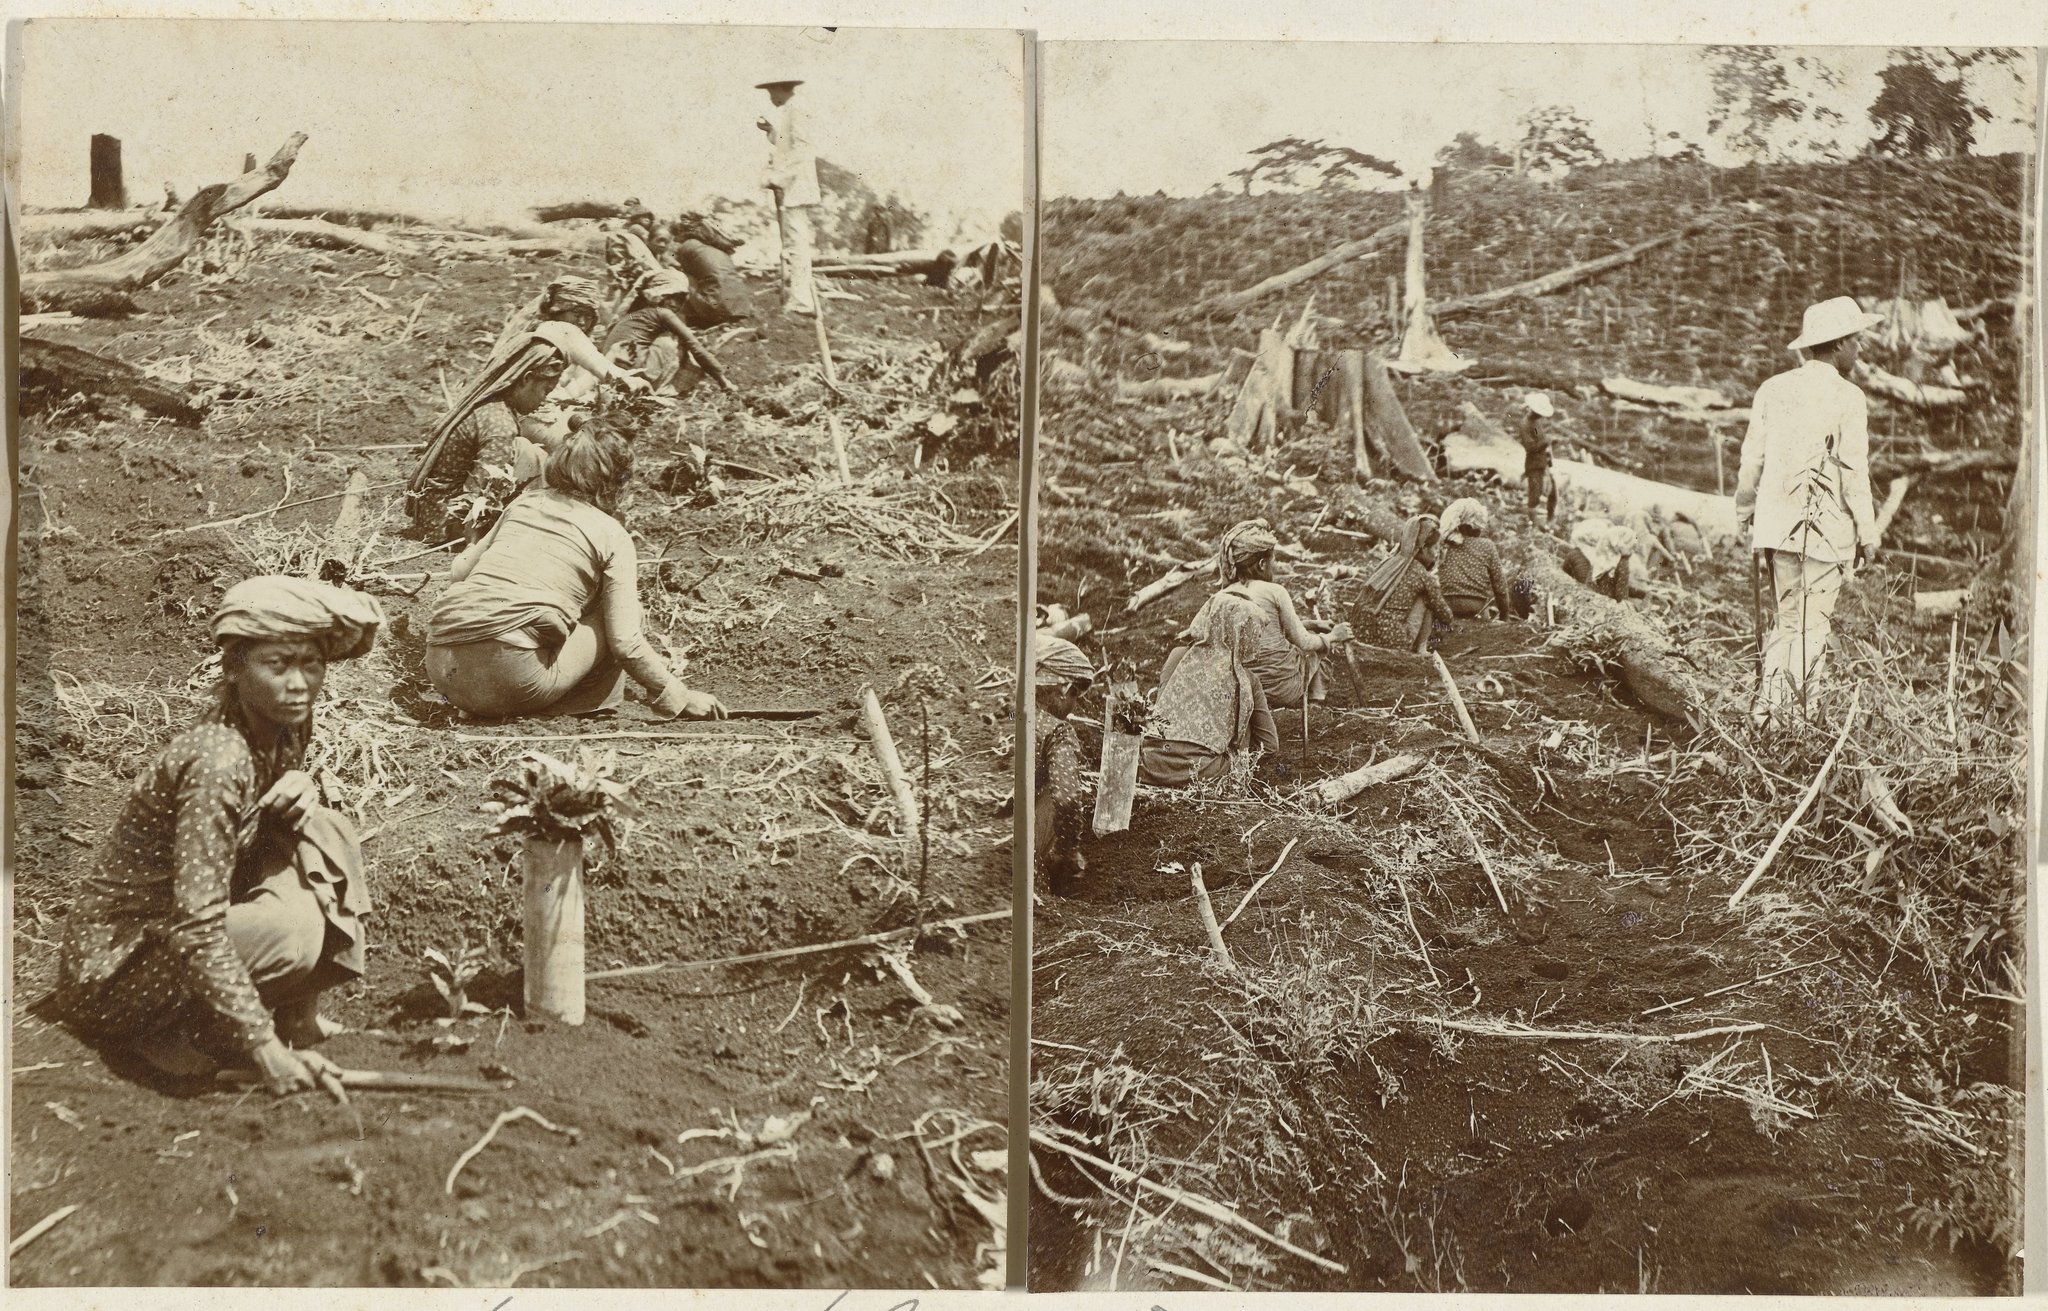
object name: photograph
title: Indonesische landarbeiders planten koffieplanten op een veld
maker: Anonymous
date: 1890-1910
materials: cardboard, paper, photographic support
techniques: gelatin silver print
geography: indonesia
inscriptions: caption: ‘Koffie planten te silo sanen’